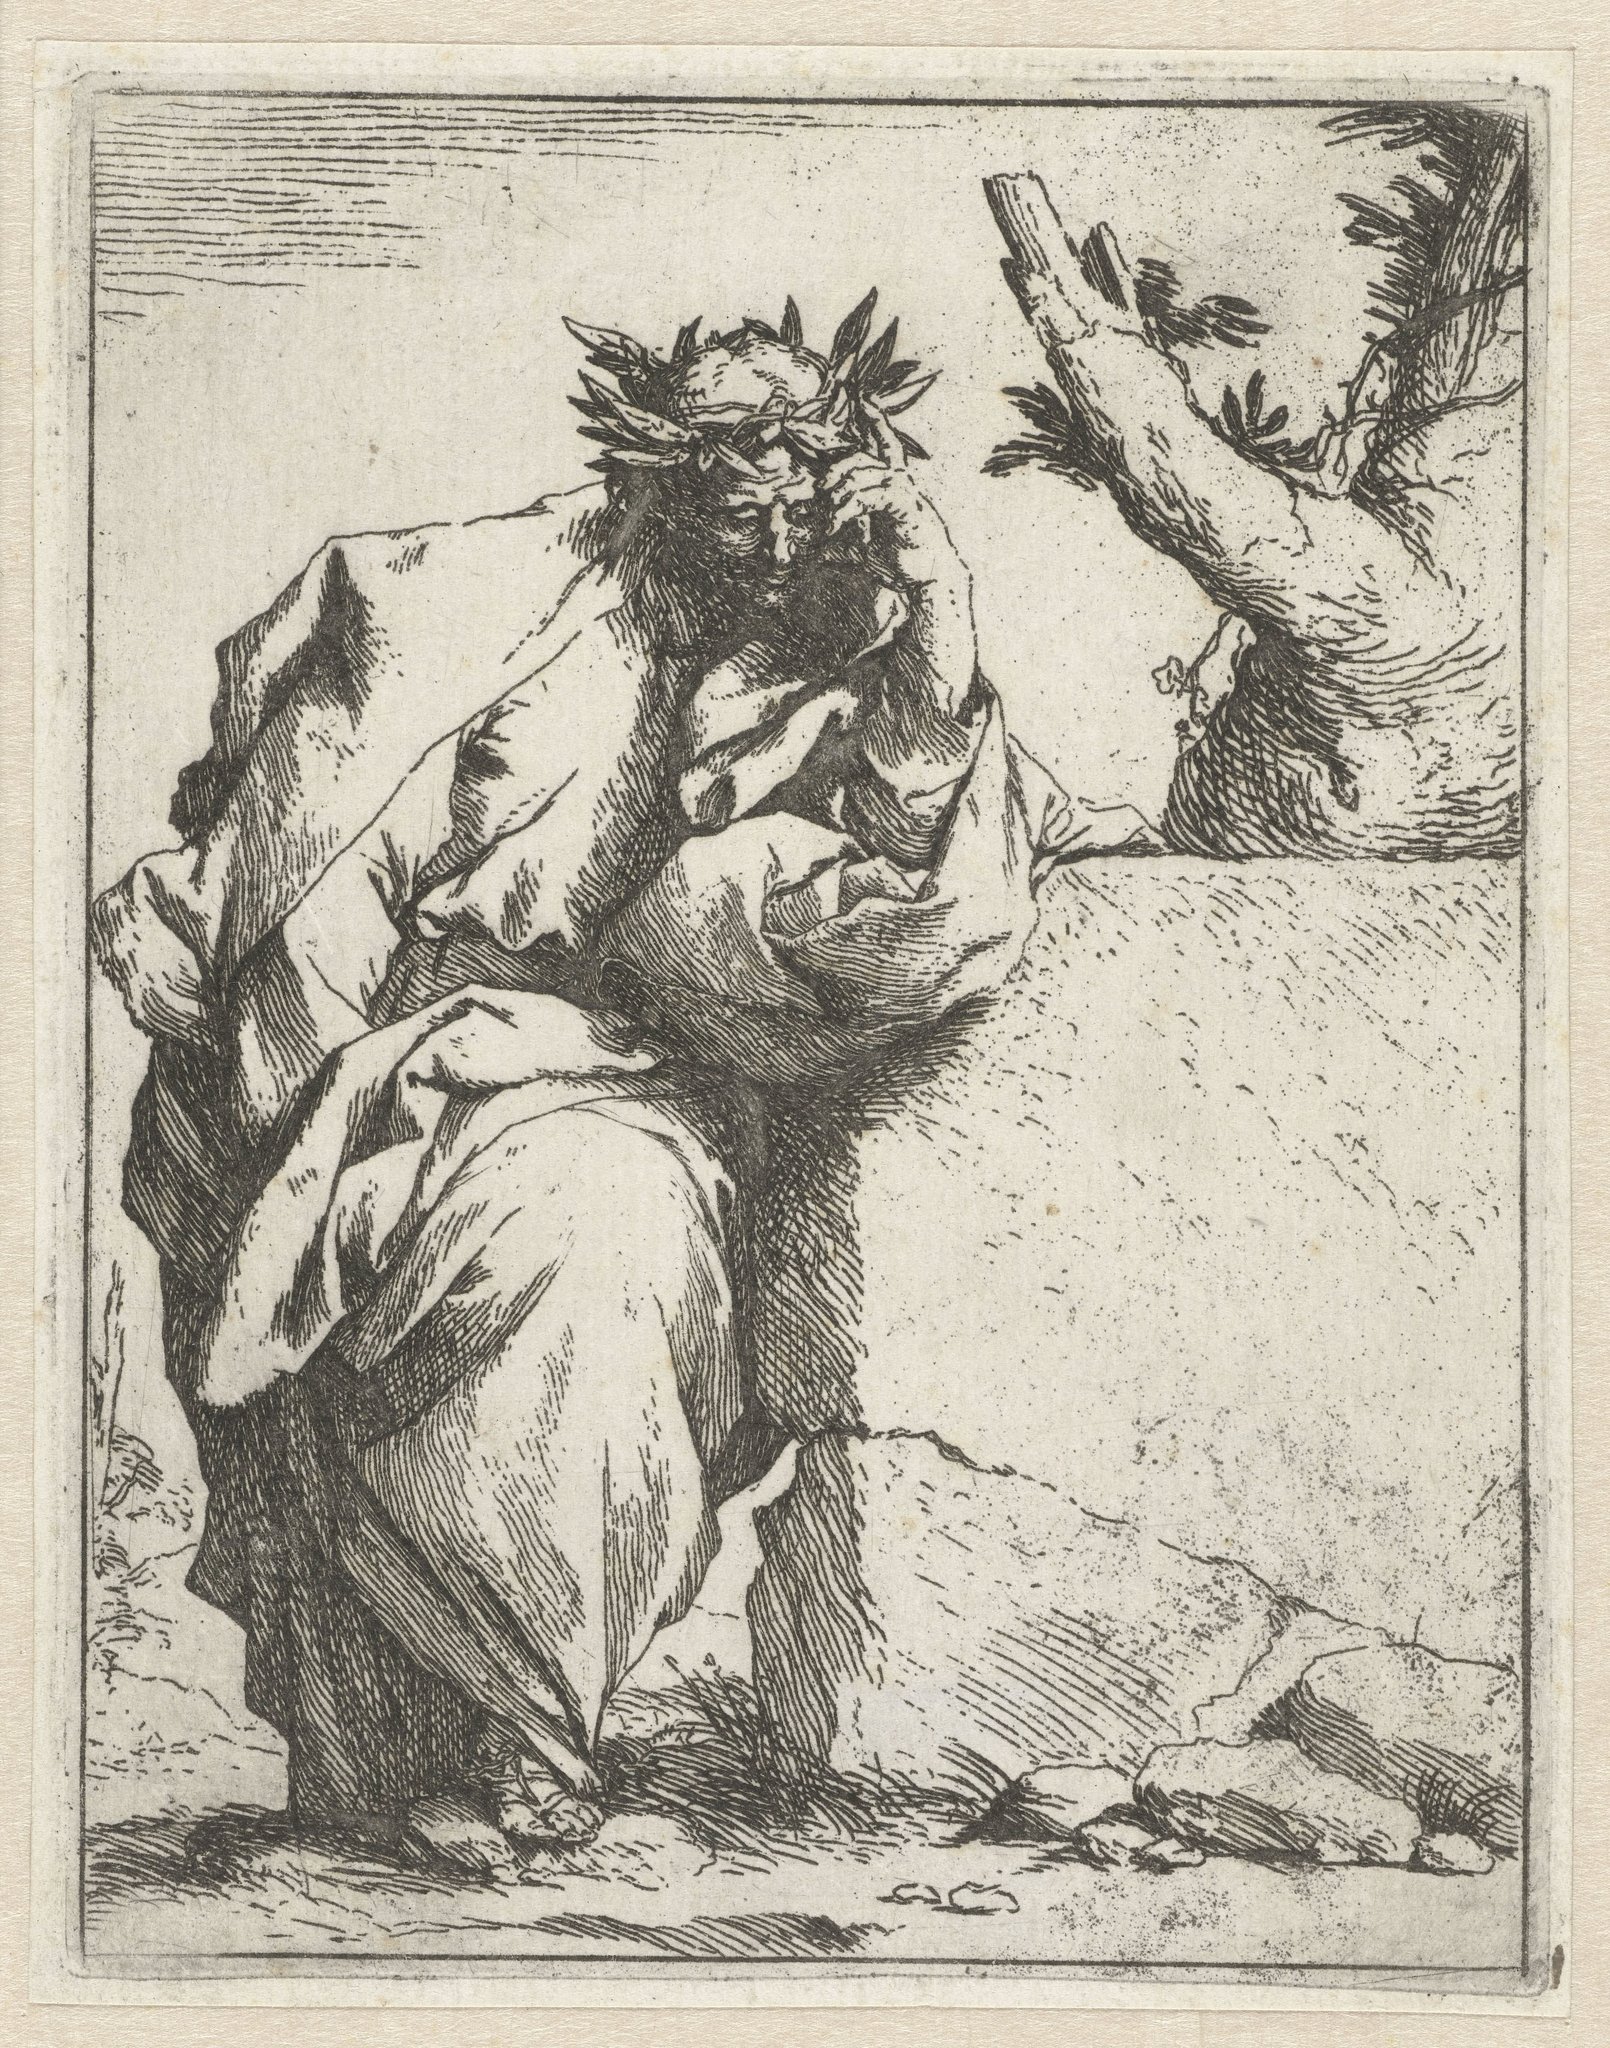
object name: print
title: Dichter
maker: jusepe de ribera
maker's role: draughtsman, painter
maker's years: 1591-1652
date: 1620-1621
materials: paper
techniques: etching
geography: naples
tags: writer, poet, author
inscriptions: collector's mark: Lugt 11, collector's mark: Lugt 10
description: Volgens Selma Holo (zie Brown, p. 66) is de pose geïnspireerd op de Heraclitus in de Atheense School van van Rafaël.